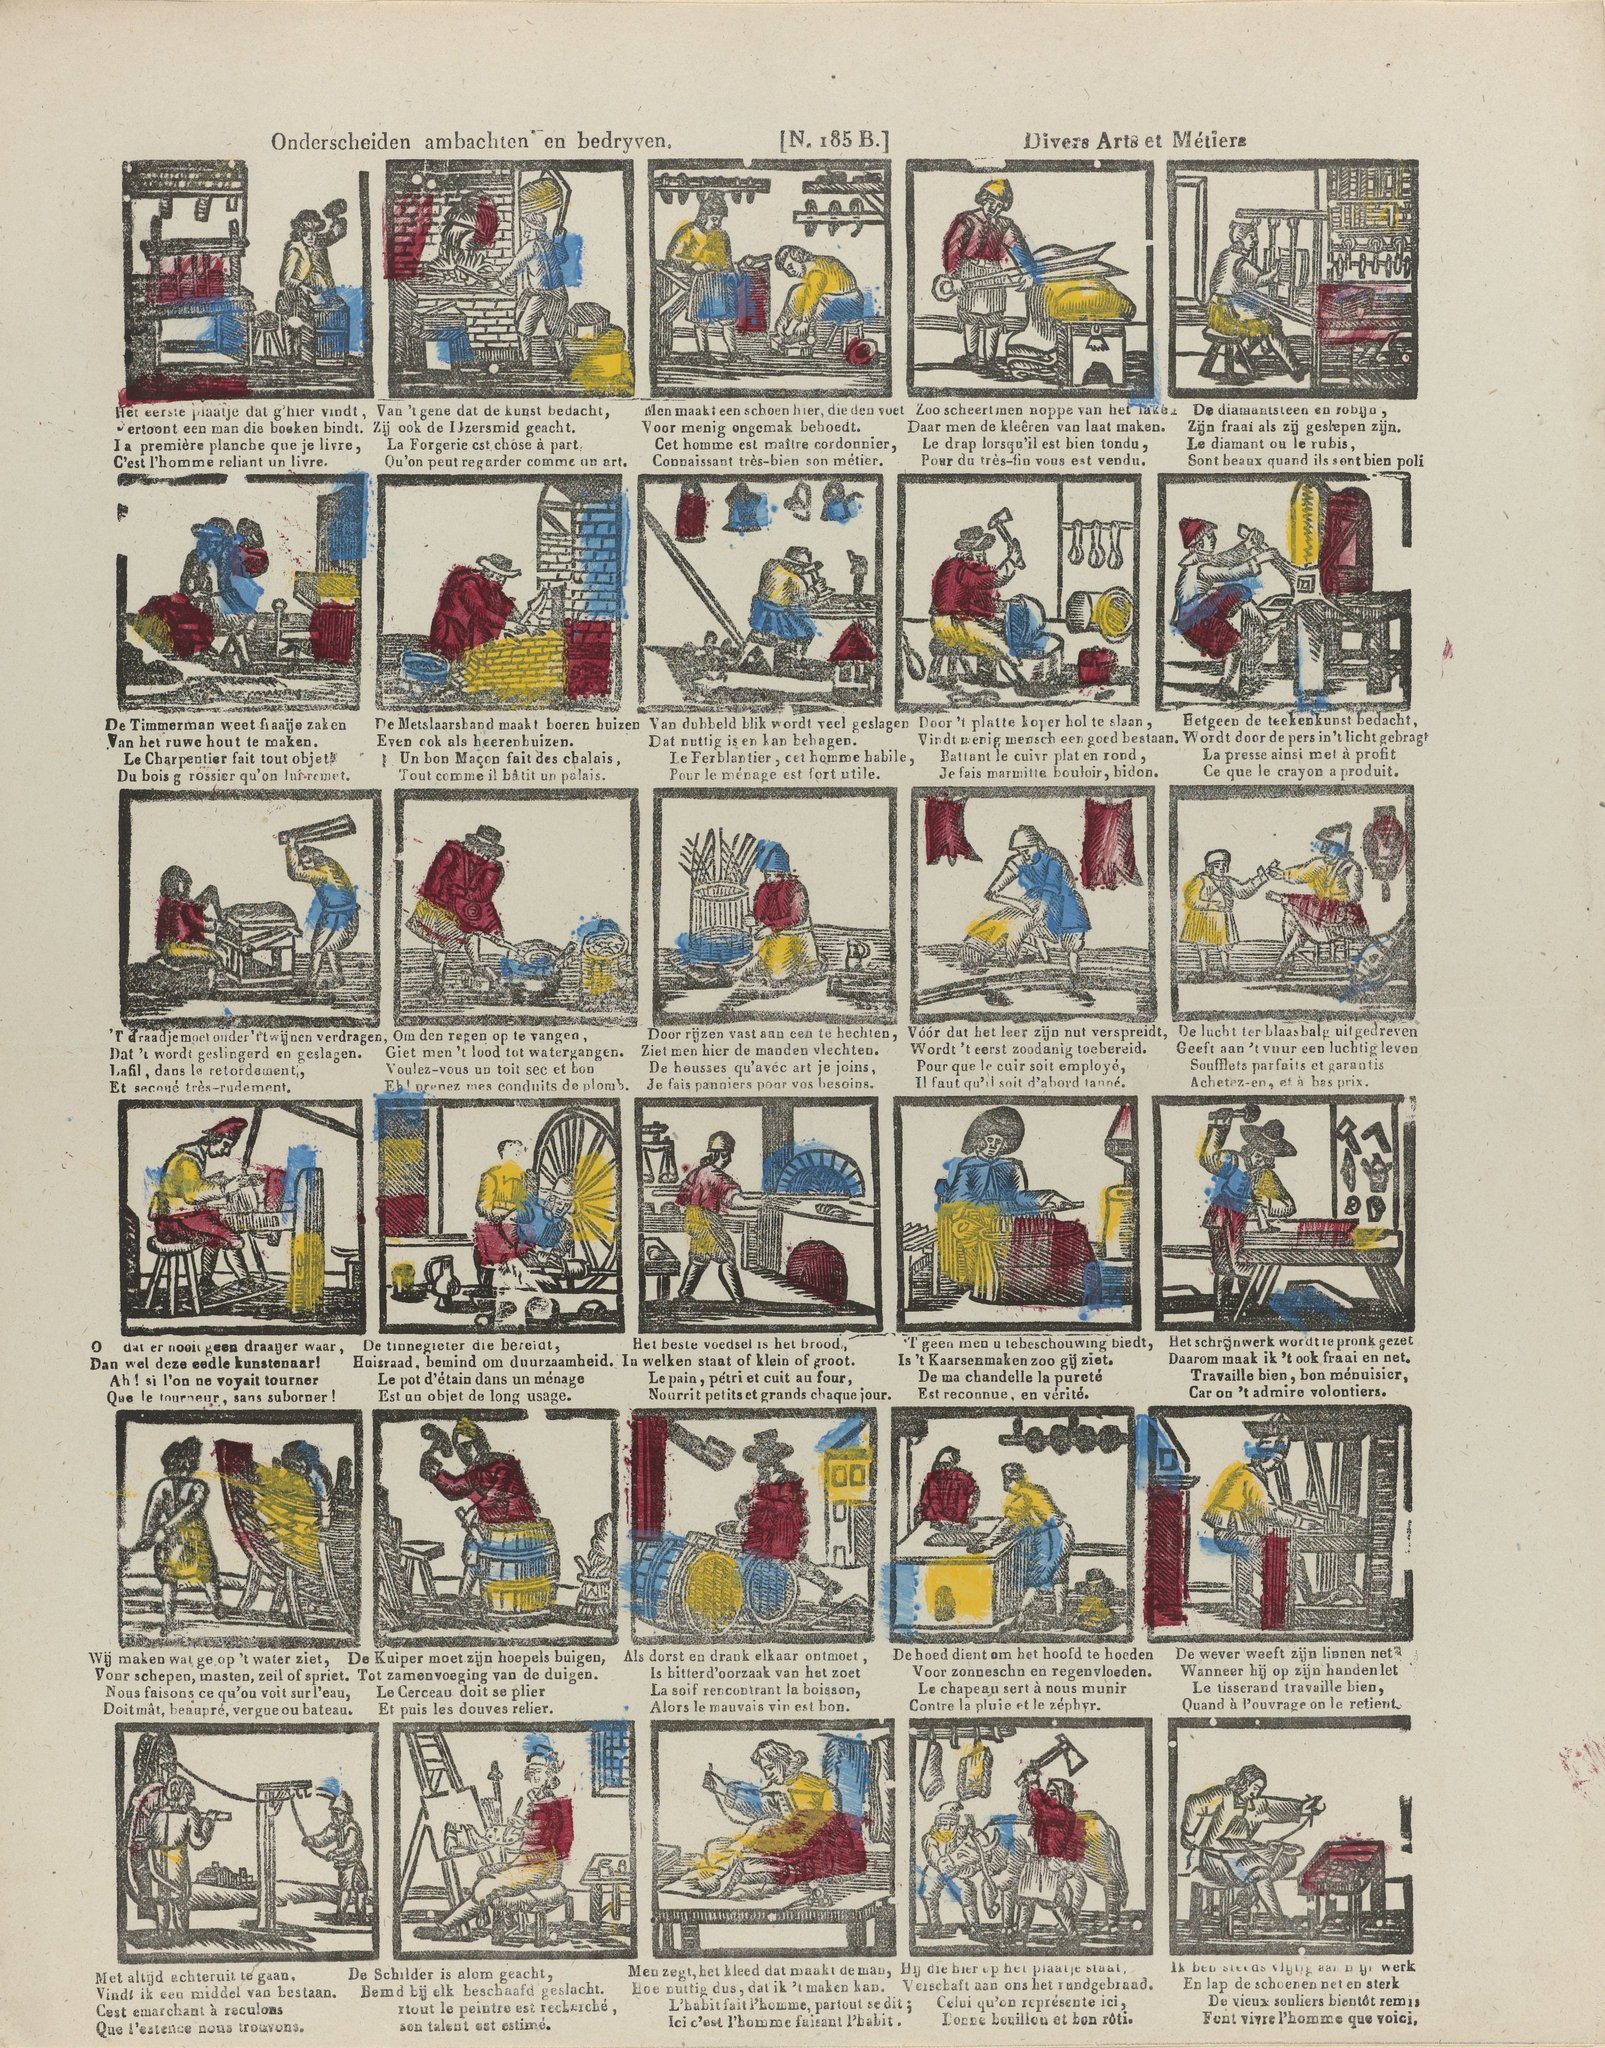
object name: popular print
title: Onderscheiden ambachten en bedryven / Divers arts et métiers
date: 1800-1833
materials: paper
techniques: colour, letterpress printing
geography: turnhout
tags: craft-production, skilled handiwork, baker, butcher, slaughterman, smith, blacksmith, crafts and industries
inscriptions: collector's mark: Lugt 2760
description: Blad met 30 voorstellingen van ambachtslieden en beroepen, zoals smid, metselaar, bakker en slager. Onder elke afbeelding een tweeregelig vers in het Nederlands en in het Frans. Genummerd midden boven: [N. 185 B.].